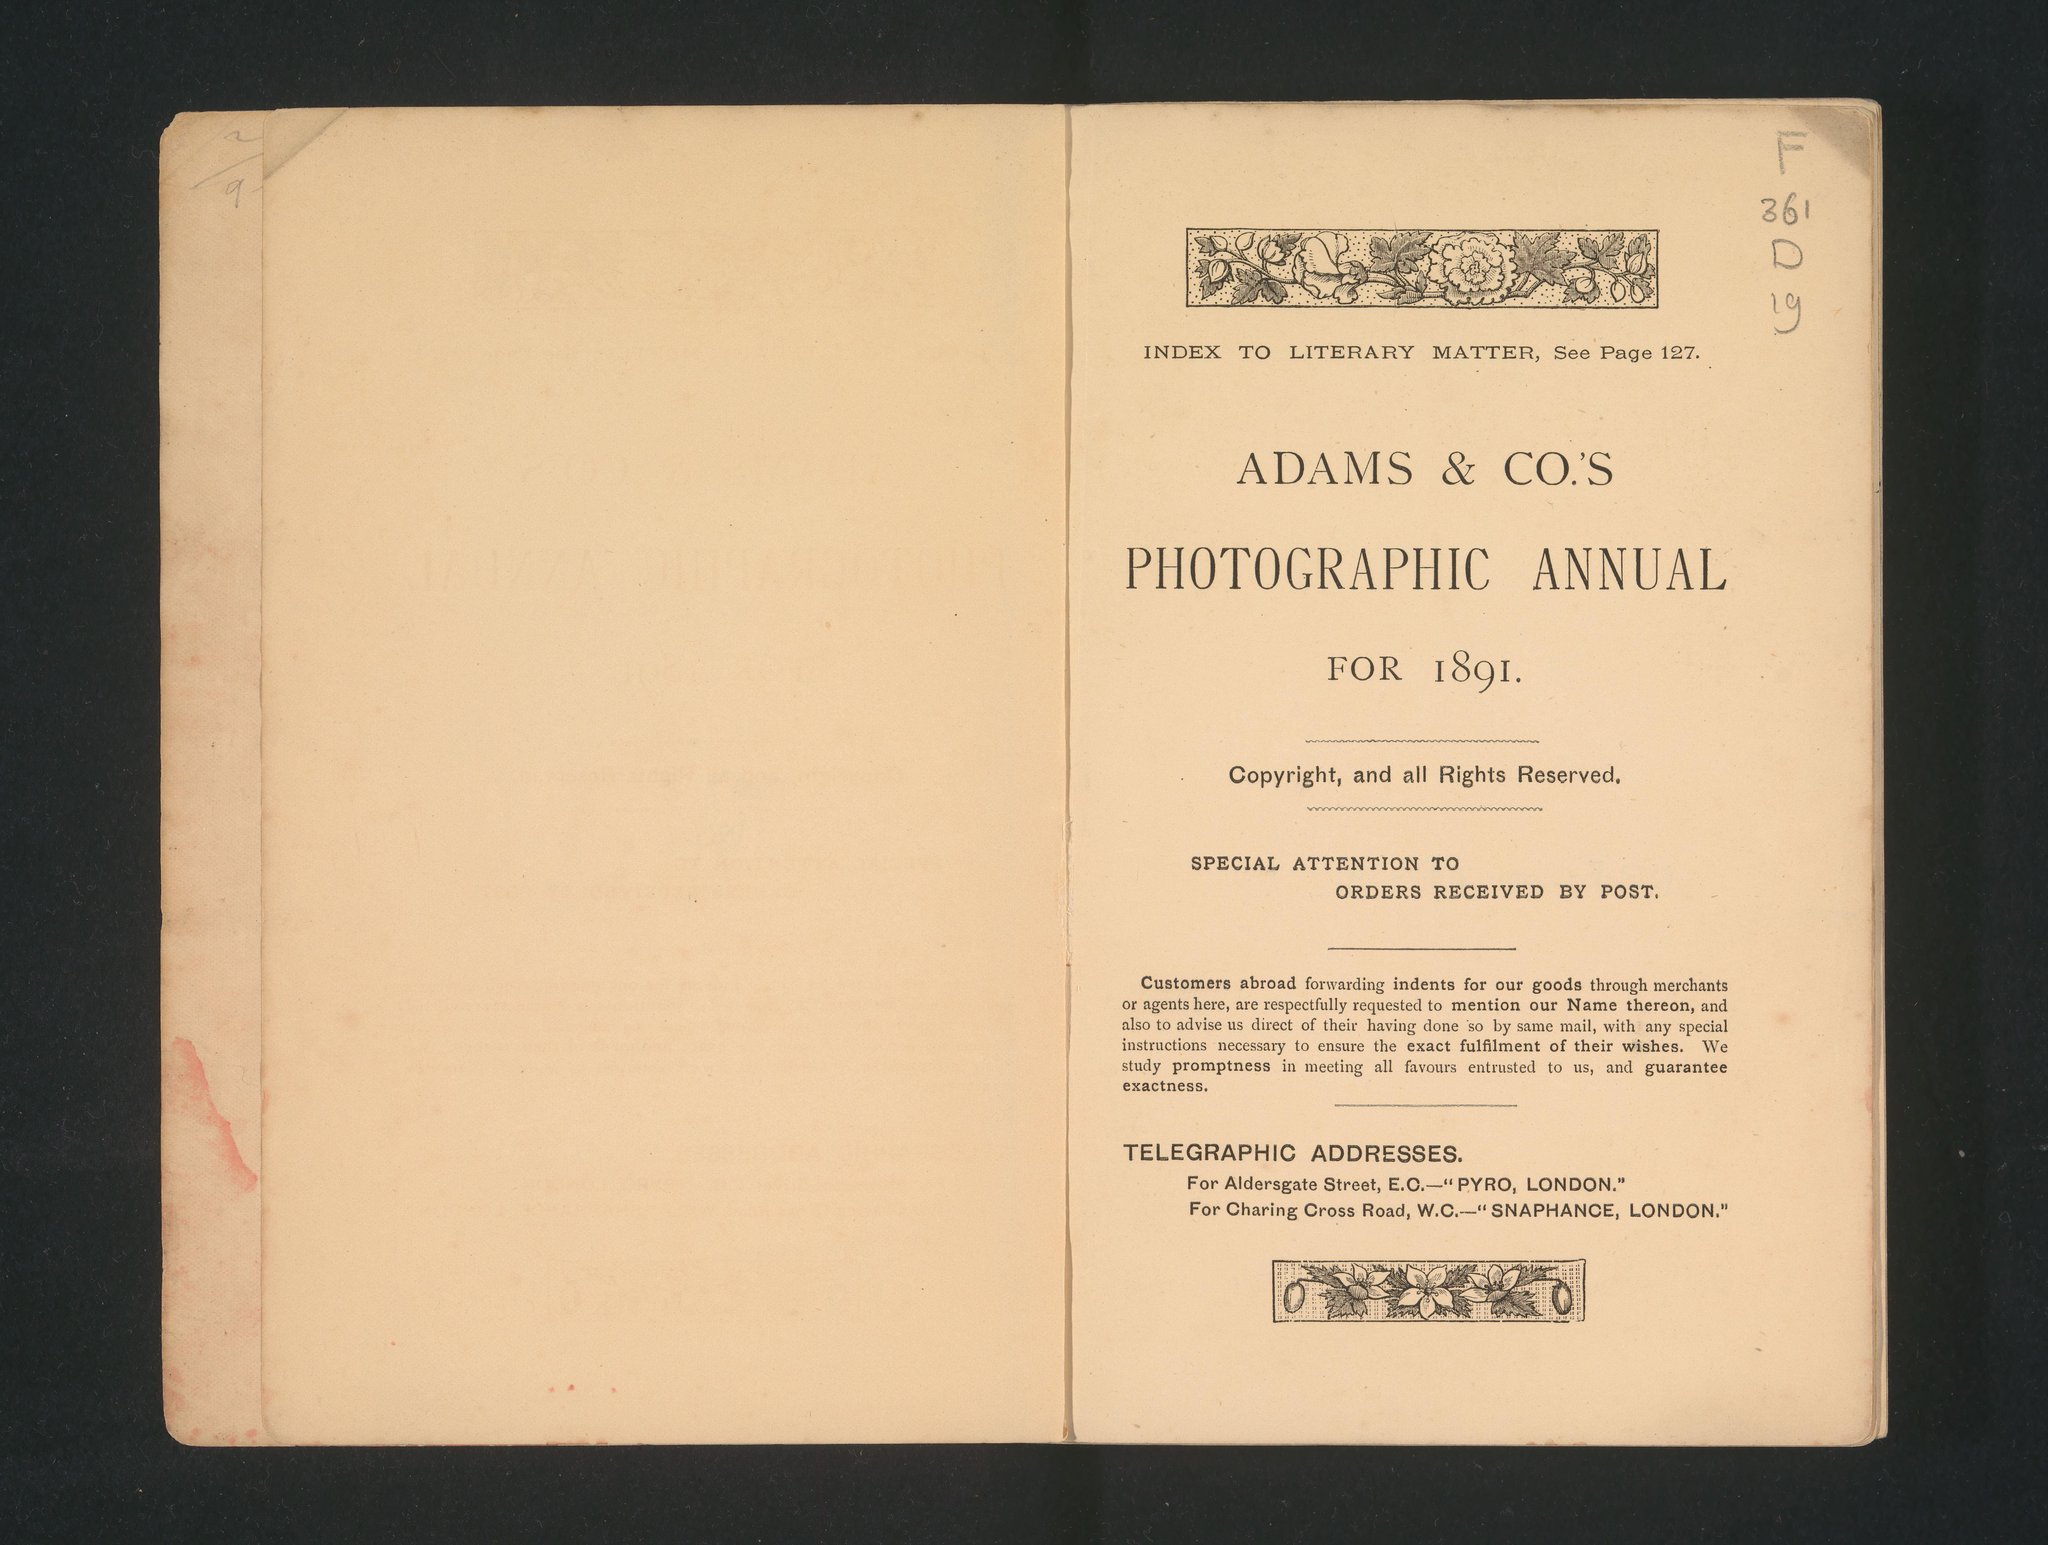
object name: book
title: Adams and Co.'s photographic annual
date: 1891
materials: linen, paper, photographic support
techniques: albumen print, gelatin silver print, printing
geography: london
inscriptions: date: ‘MAY 1984’, annotation: ‘2/9-20’